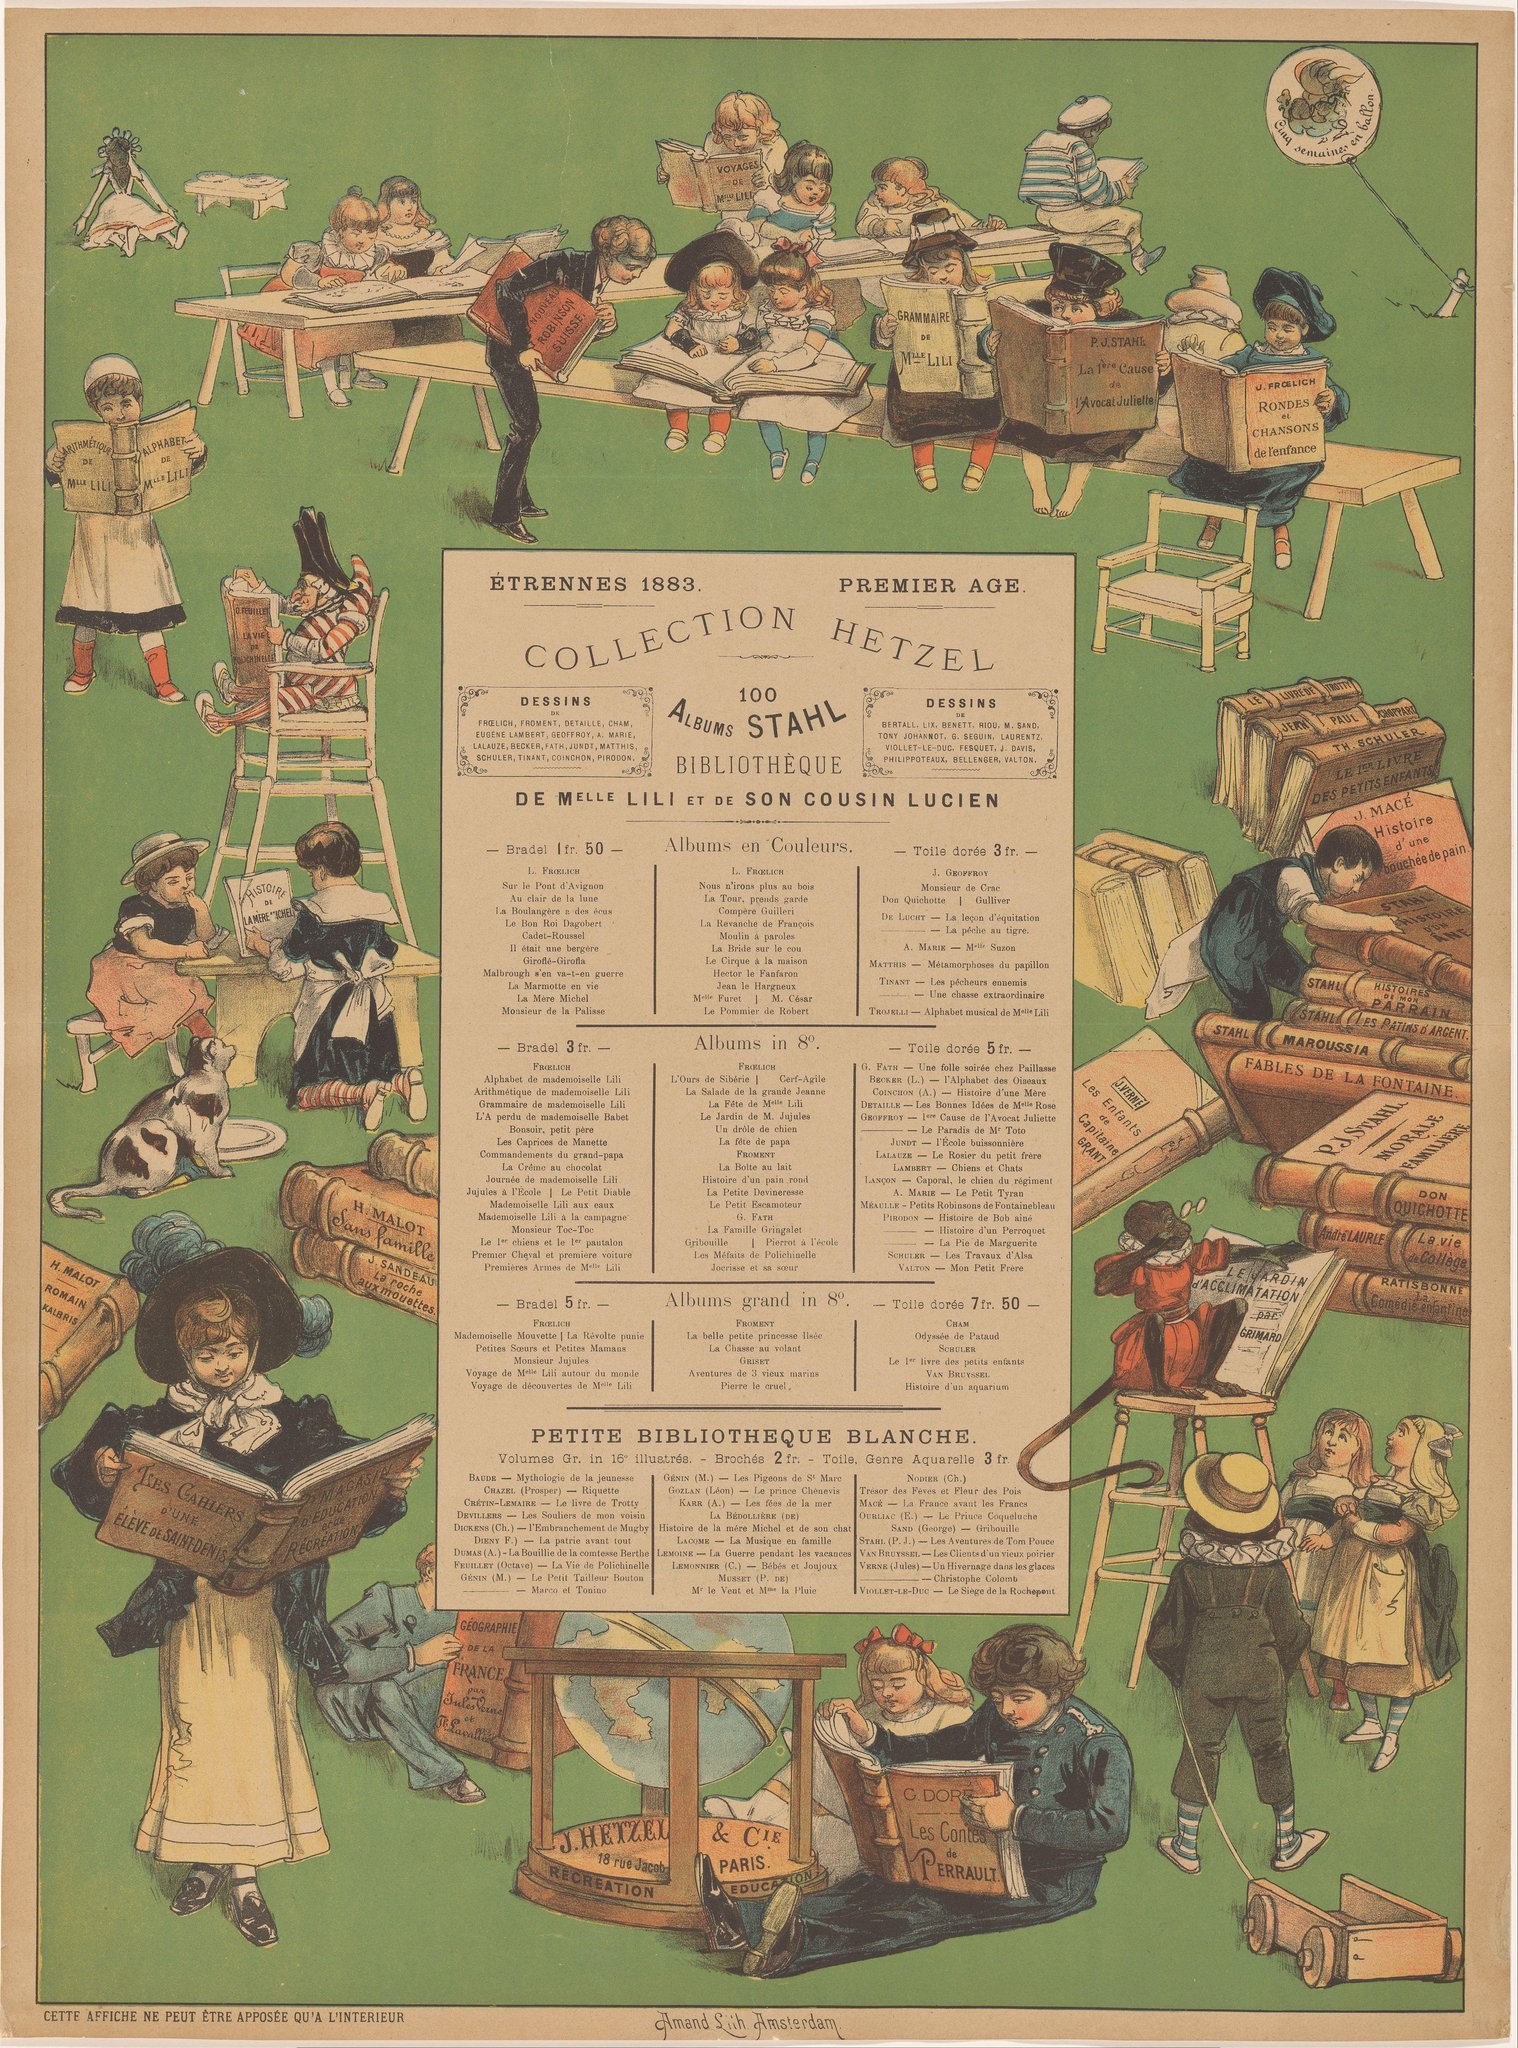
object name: fondslijst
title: Catalogue of J. Hetzel & Cie in Paris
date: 1883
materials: paper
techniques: lithograph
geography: paris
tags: reading, children's books, book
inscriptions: collector's mark: Lugt 4780, collector's mark: Lugt 2228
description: The French publisher Pierre-Jules Hetzel established his own publishing house in 1837. He is best known for his lavishly illustrated editions of Jules Verne’s novels, which combined imagination and pedagogy. Framed with children absorbed in books from his publishing house, this brochure lists all the titles available in 1883, including Hetzel’s own stories written under the pseudonym P.-J. Stahl.